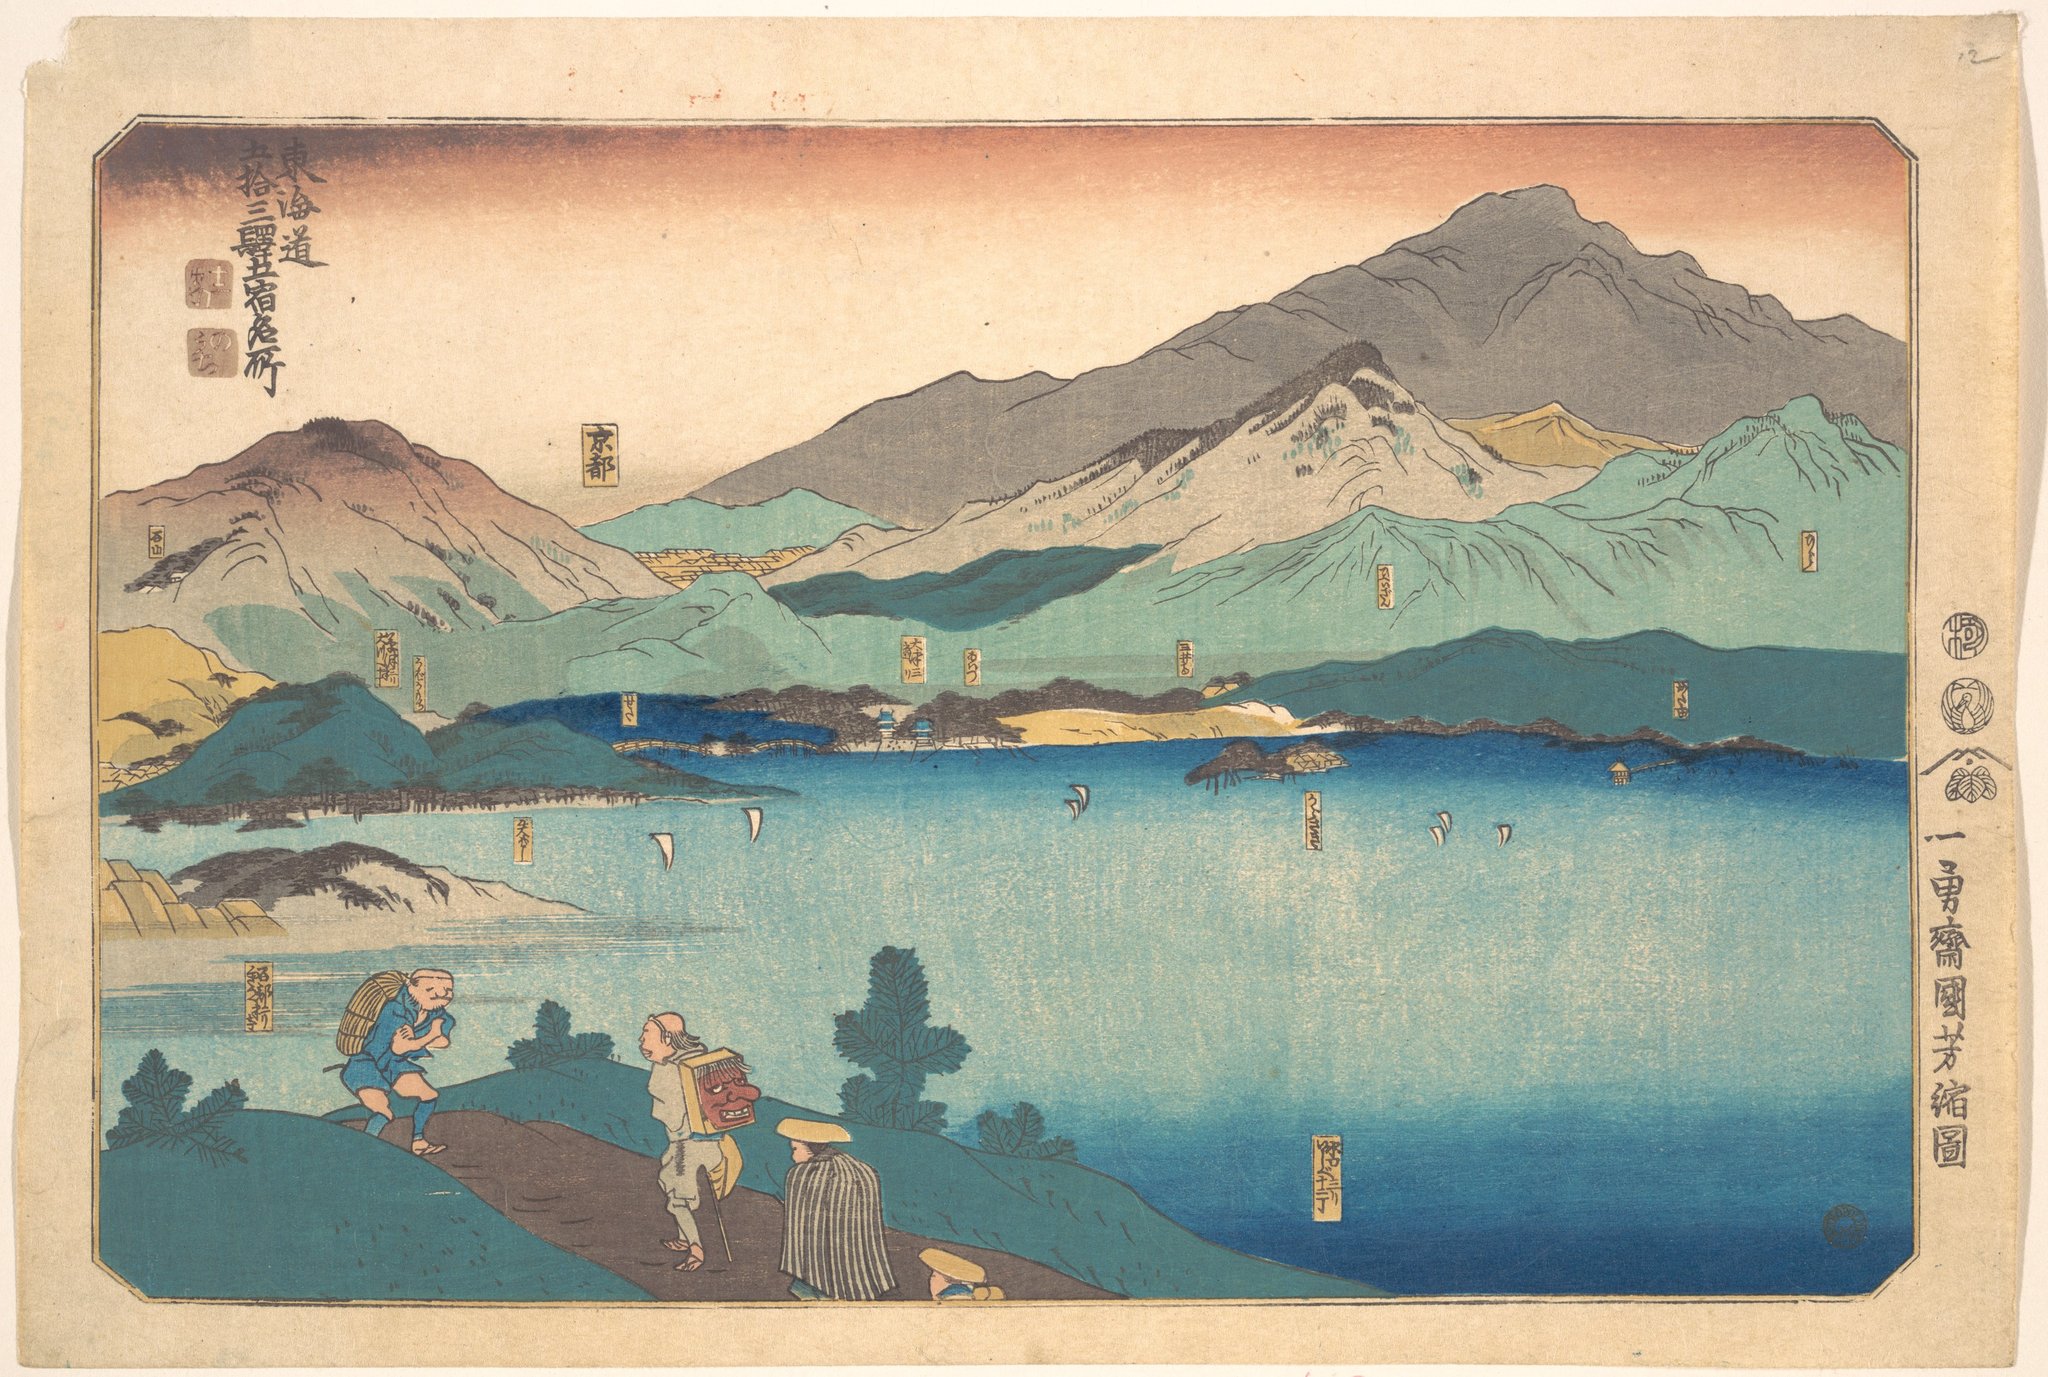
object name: print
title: Minakuchi, Ishibe, Kusatsu, Otsu, Kyoto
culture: japanese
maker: utagawa kuniyoshi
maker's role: artist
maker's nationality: japanese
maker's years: 1797-1861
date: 1840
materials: ink, paper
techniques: woodblock print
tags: men,mountains,landscapes